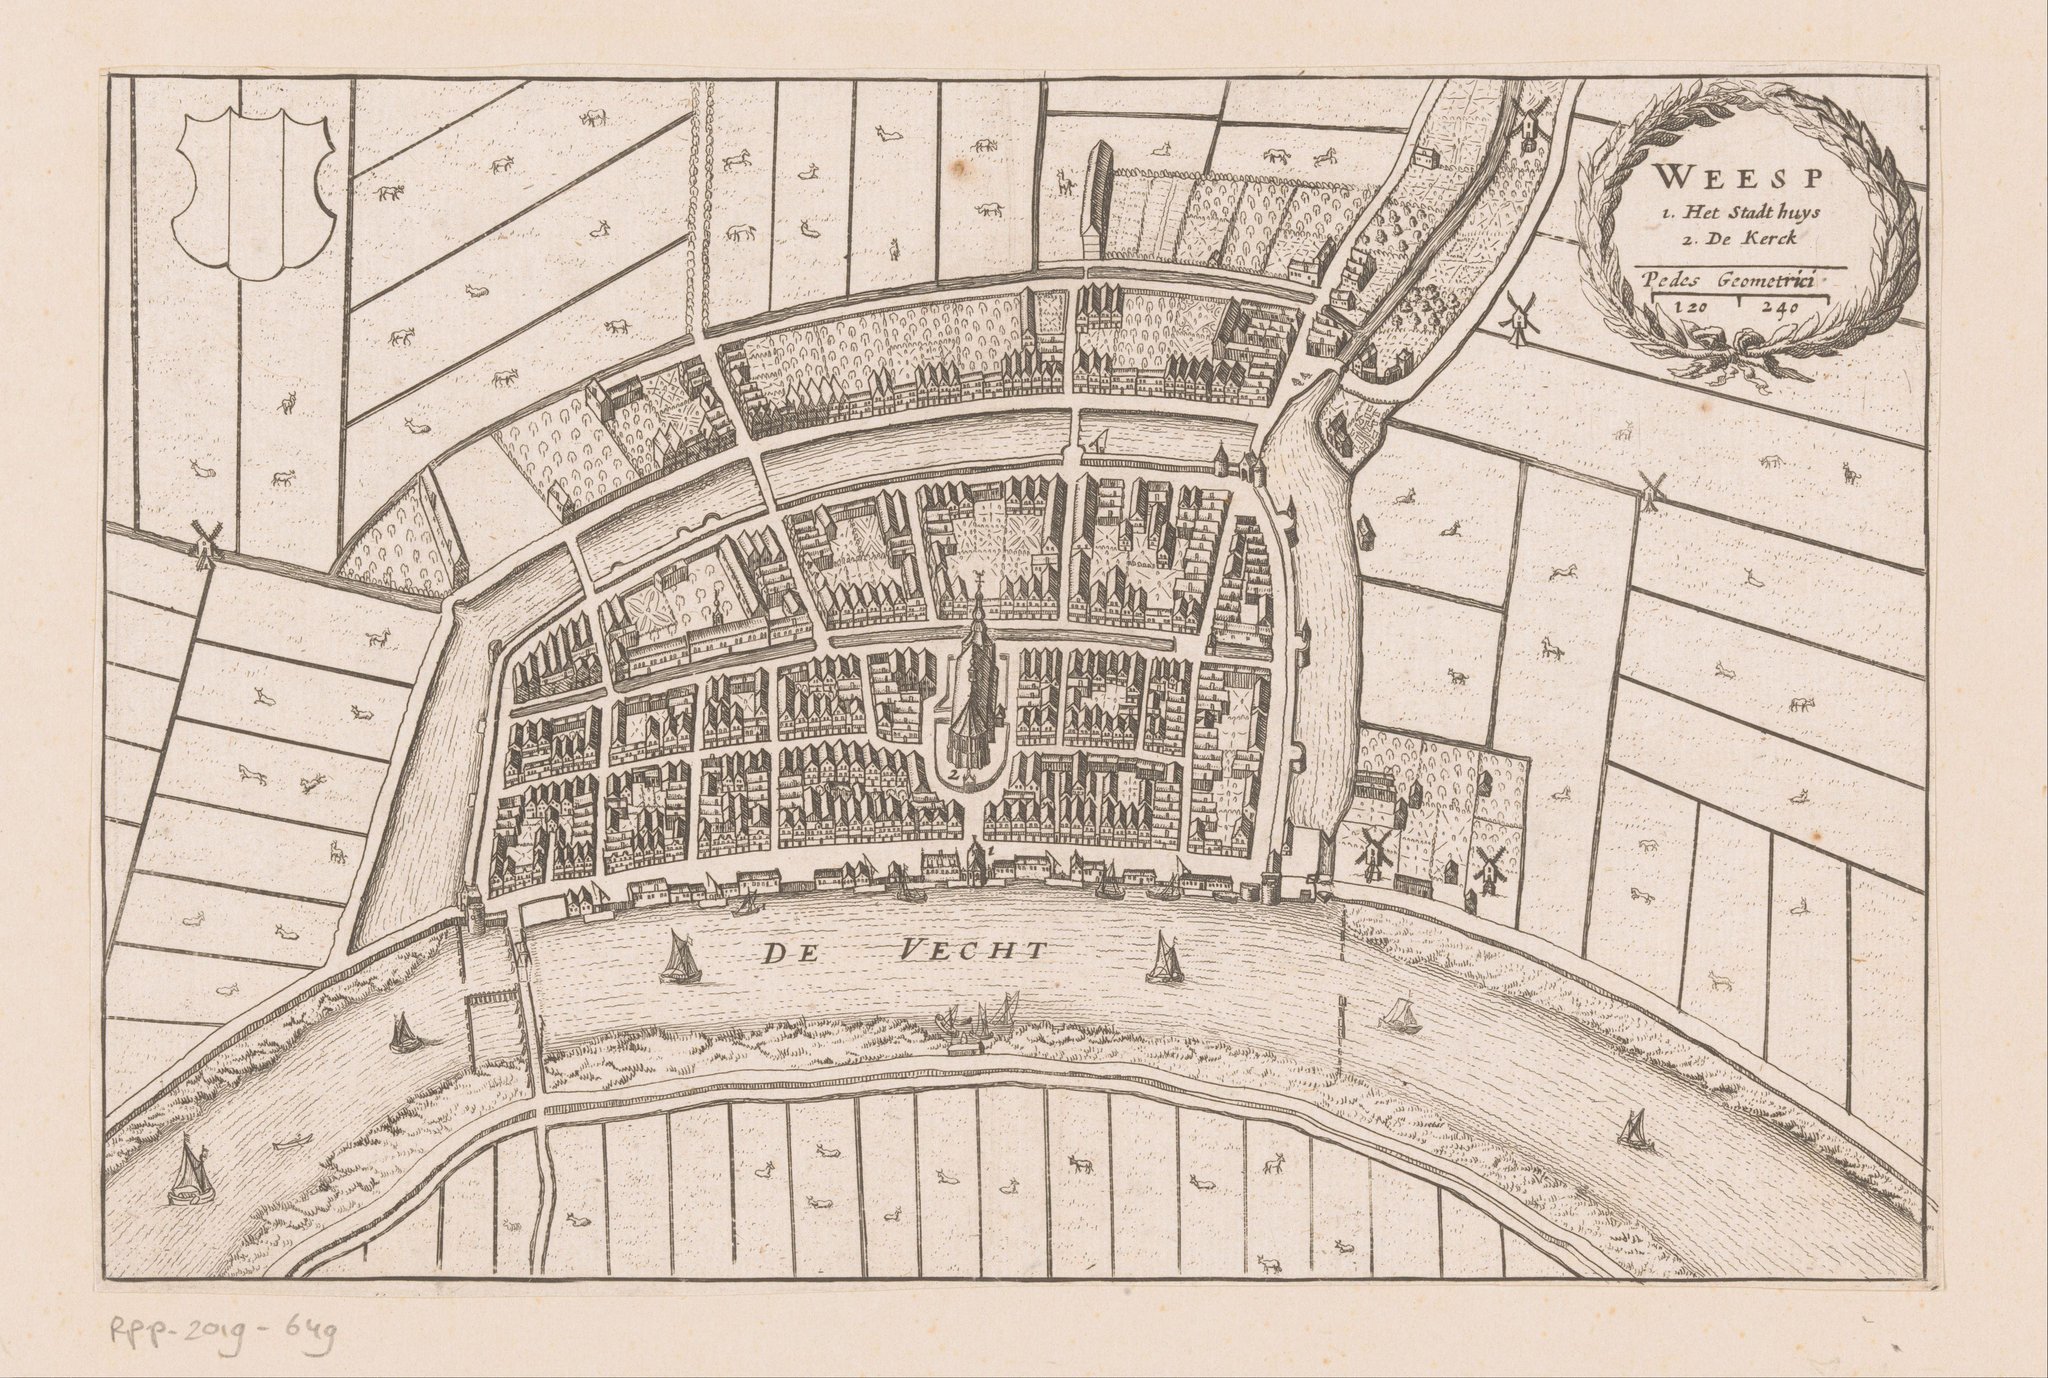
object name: area plan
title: Plattegrond van Weesp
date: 1649-1652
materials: paper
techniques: etching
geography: amsterdam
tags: maps, atlases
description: Plattegrond in vogelvluchtperspectief. Linksboven het wapen van Weesp. Rechtsboven een cartouche met de titel, legenda en een schaalstok: 240 pedes geometrici. Op verso Nederlandse tekst.